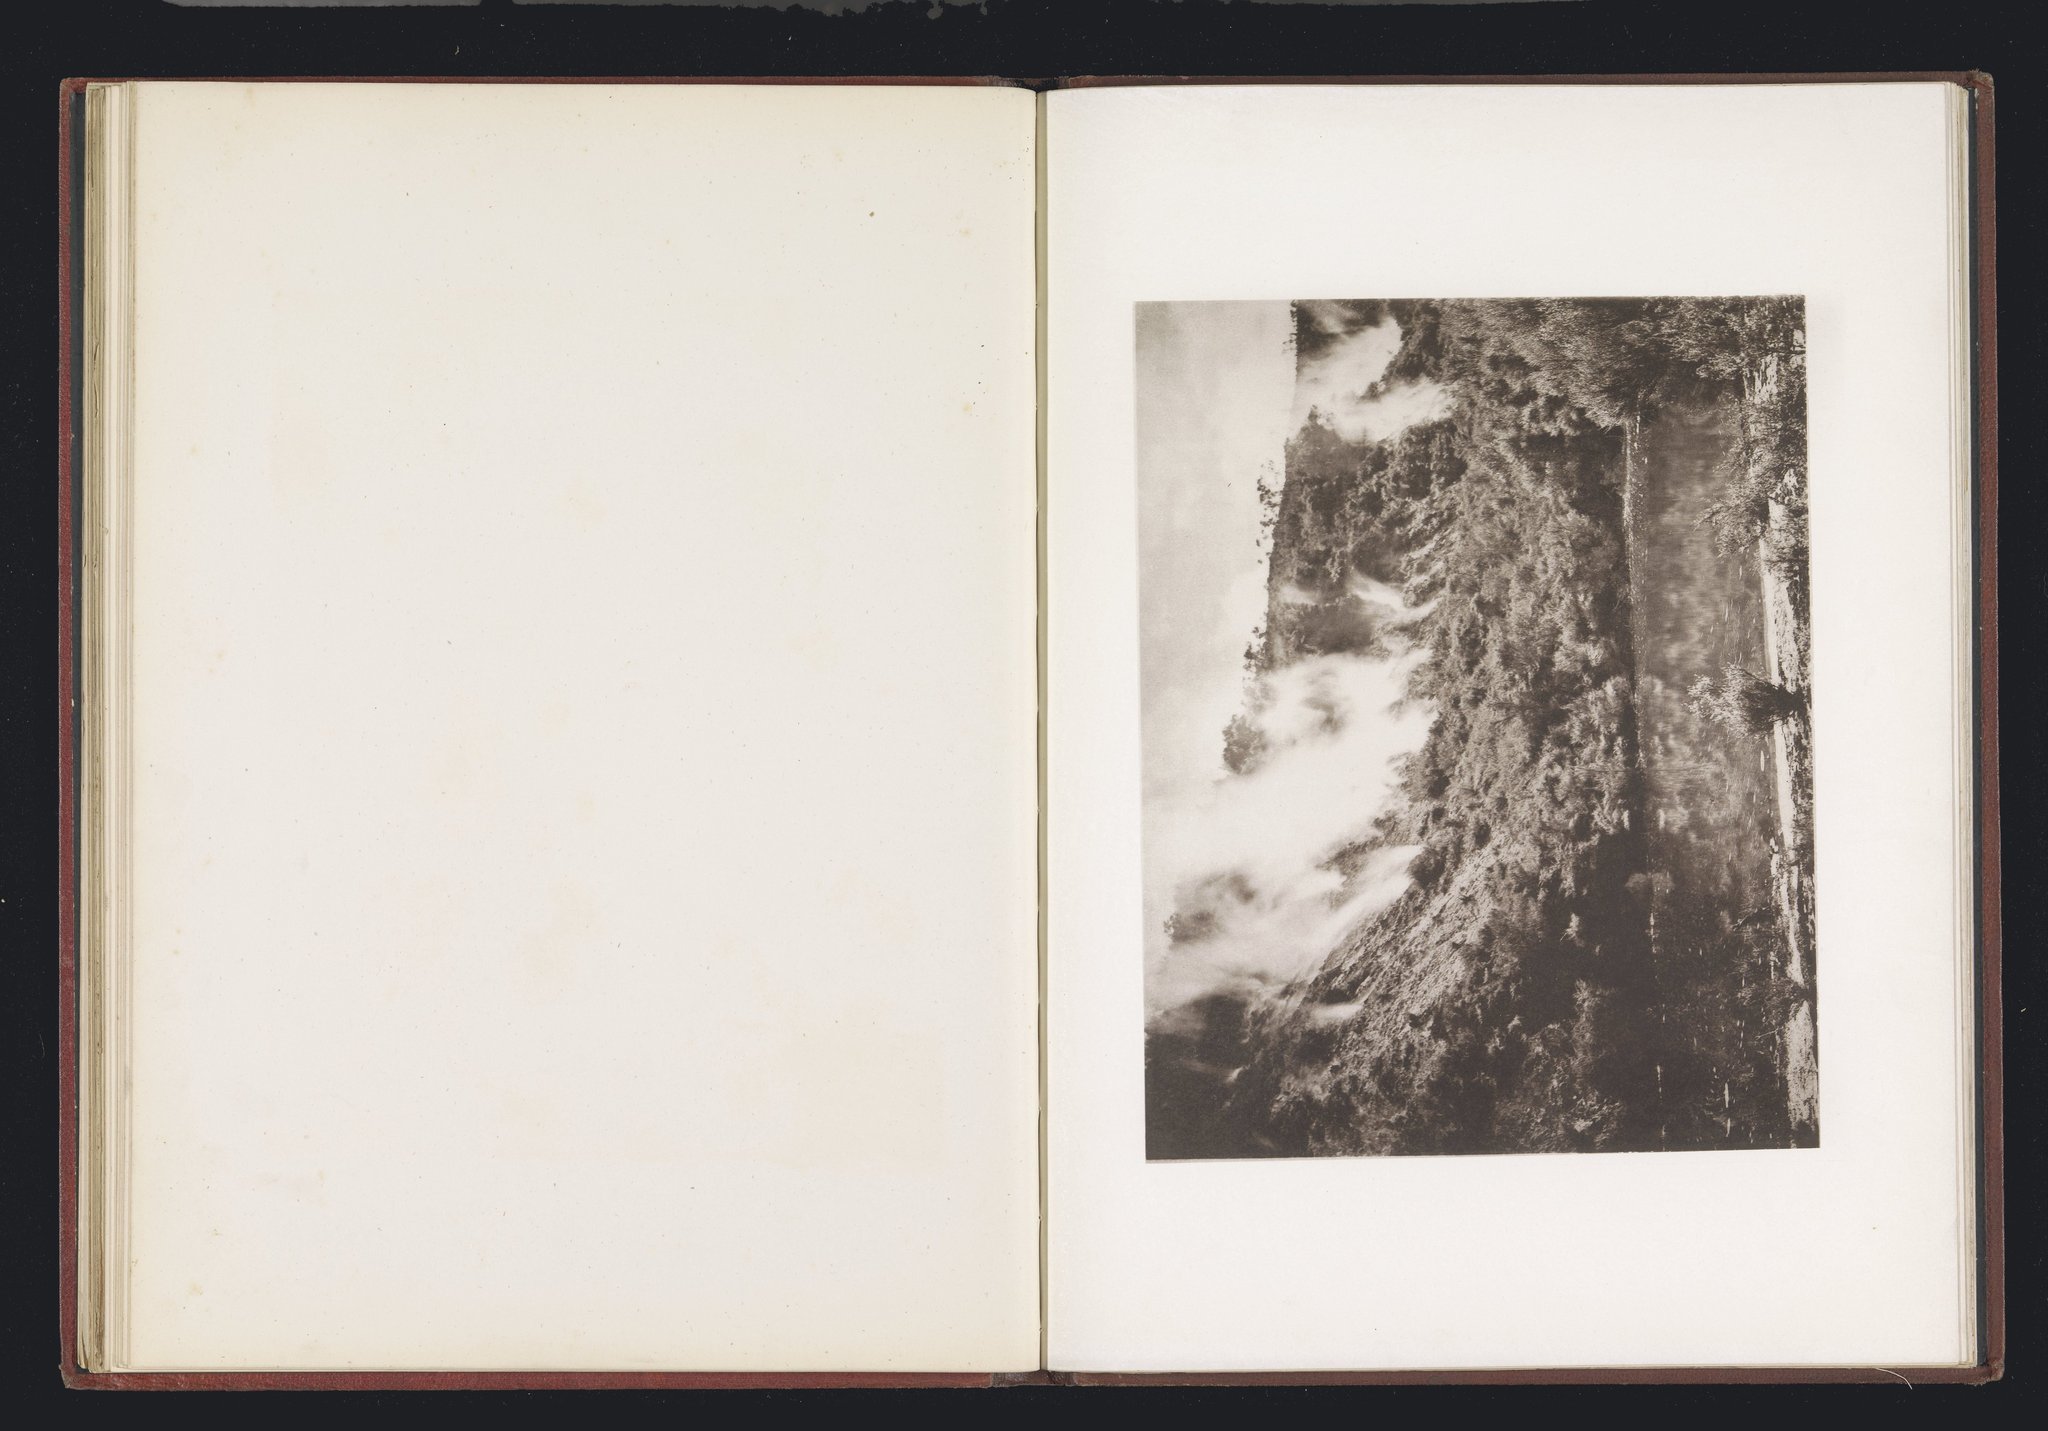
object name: page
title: Gezicht op stoomwolken langs Lake Rotomahana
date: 1865-1875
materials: paper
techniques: photograph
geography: united kingdom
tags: steam, hot spring, geyser, lake